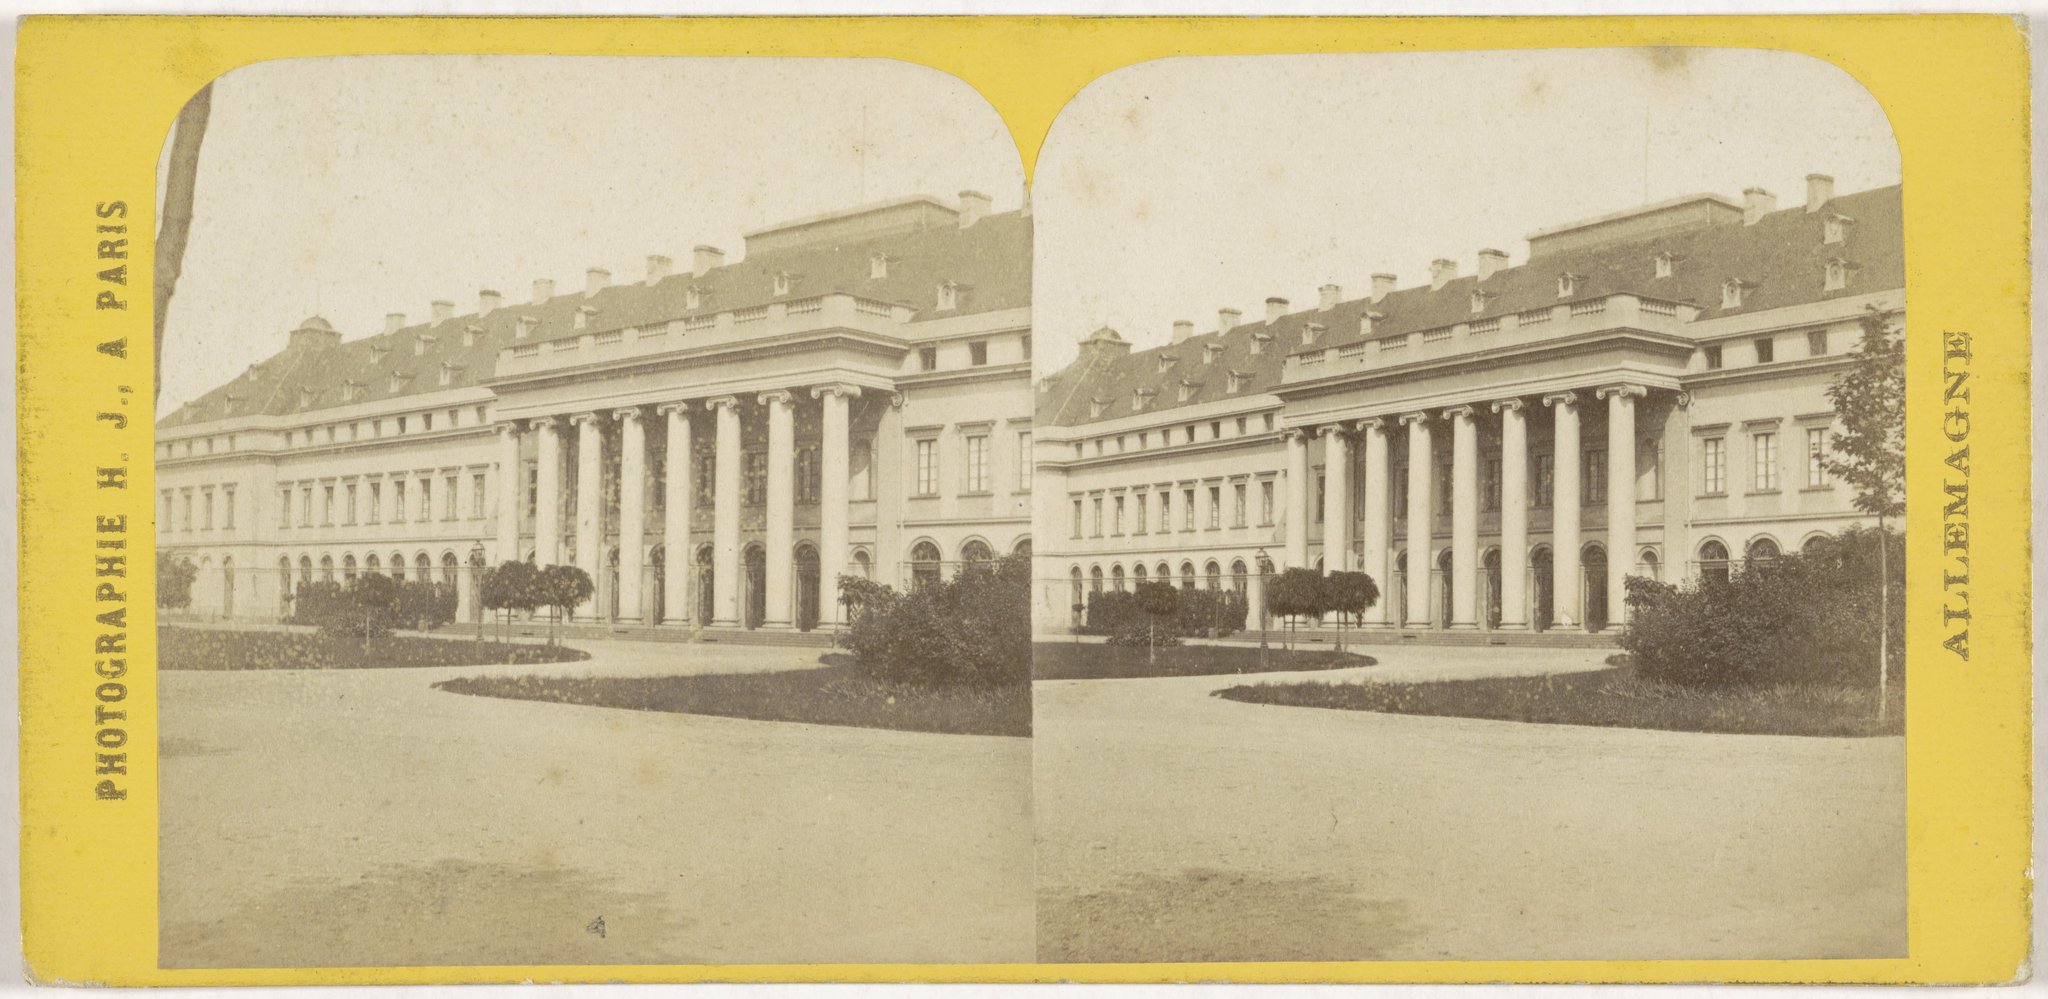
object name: stereograph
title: Allemagne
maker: hippolyte jouvin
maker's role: fotograaf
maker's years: 1825-1889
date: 1864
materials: cardboard, paper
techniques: albumen print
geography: koblenz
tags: palace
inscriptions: number: ‘515’